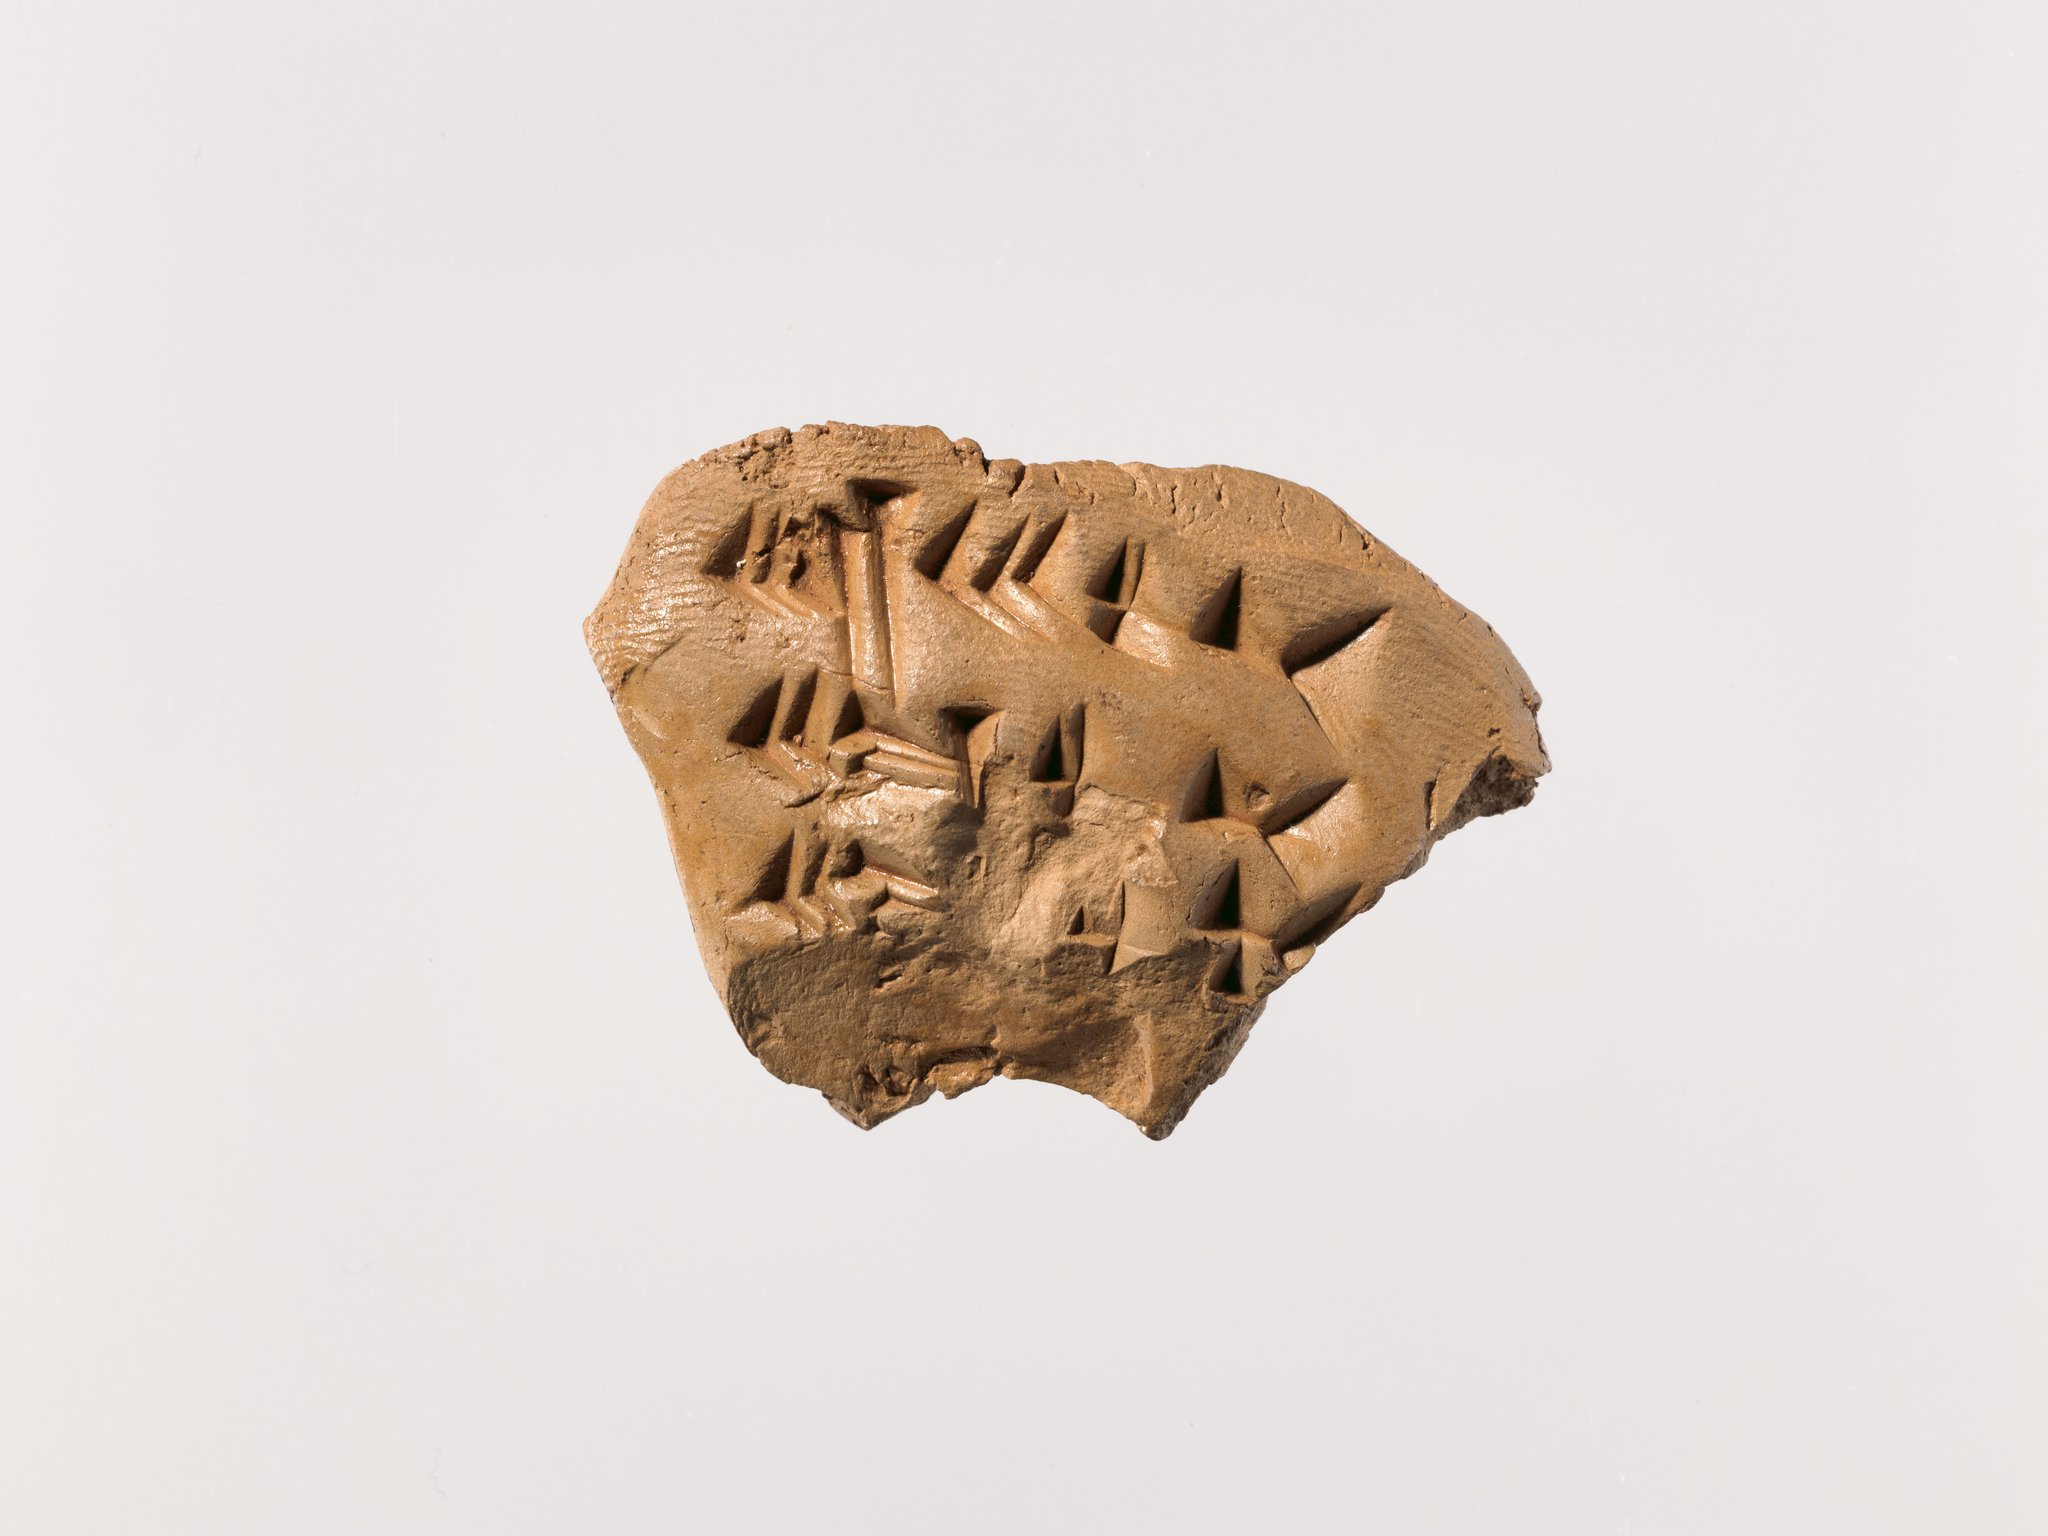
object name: bulla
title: Bulla: inventory of the contents of a container (?)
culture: achaemenid or babylonian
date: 1000-1 BCE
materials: clay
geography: mesopotamia